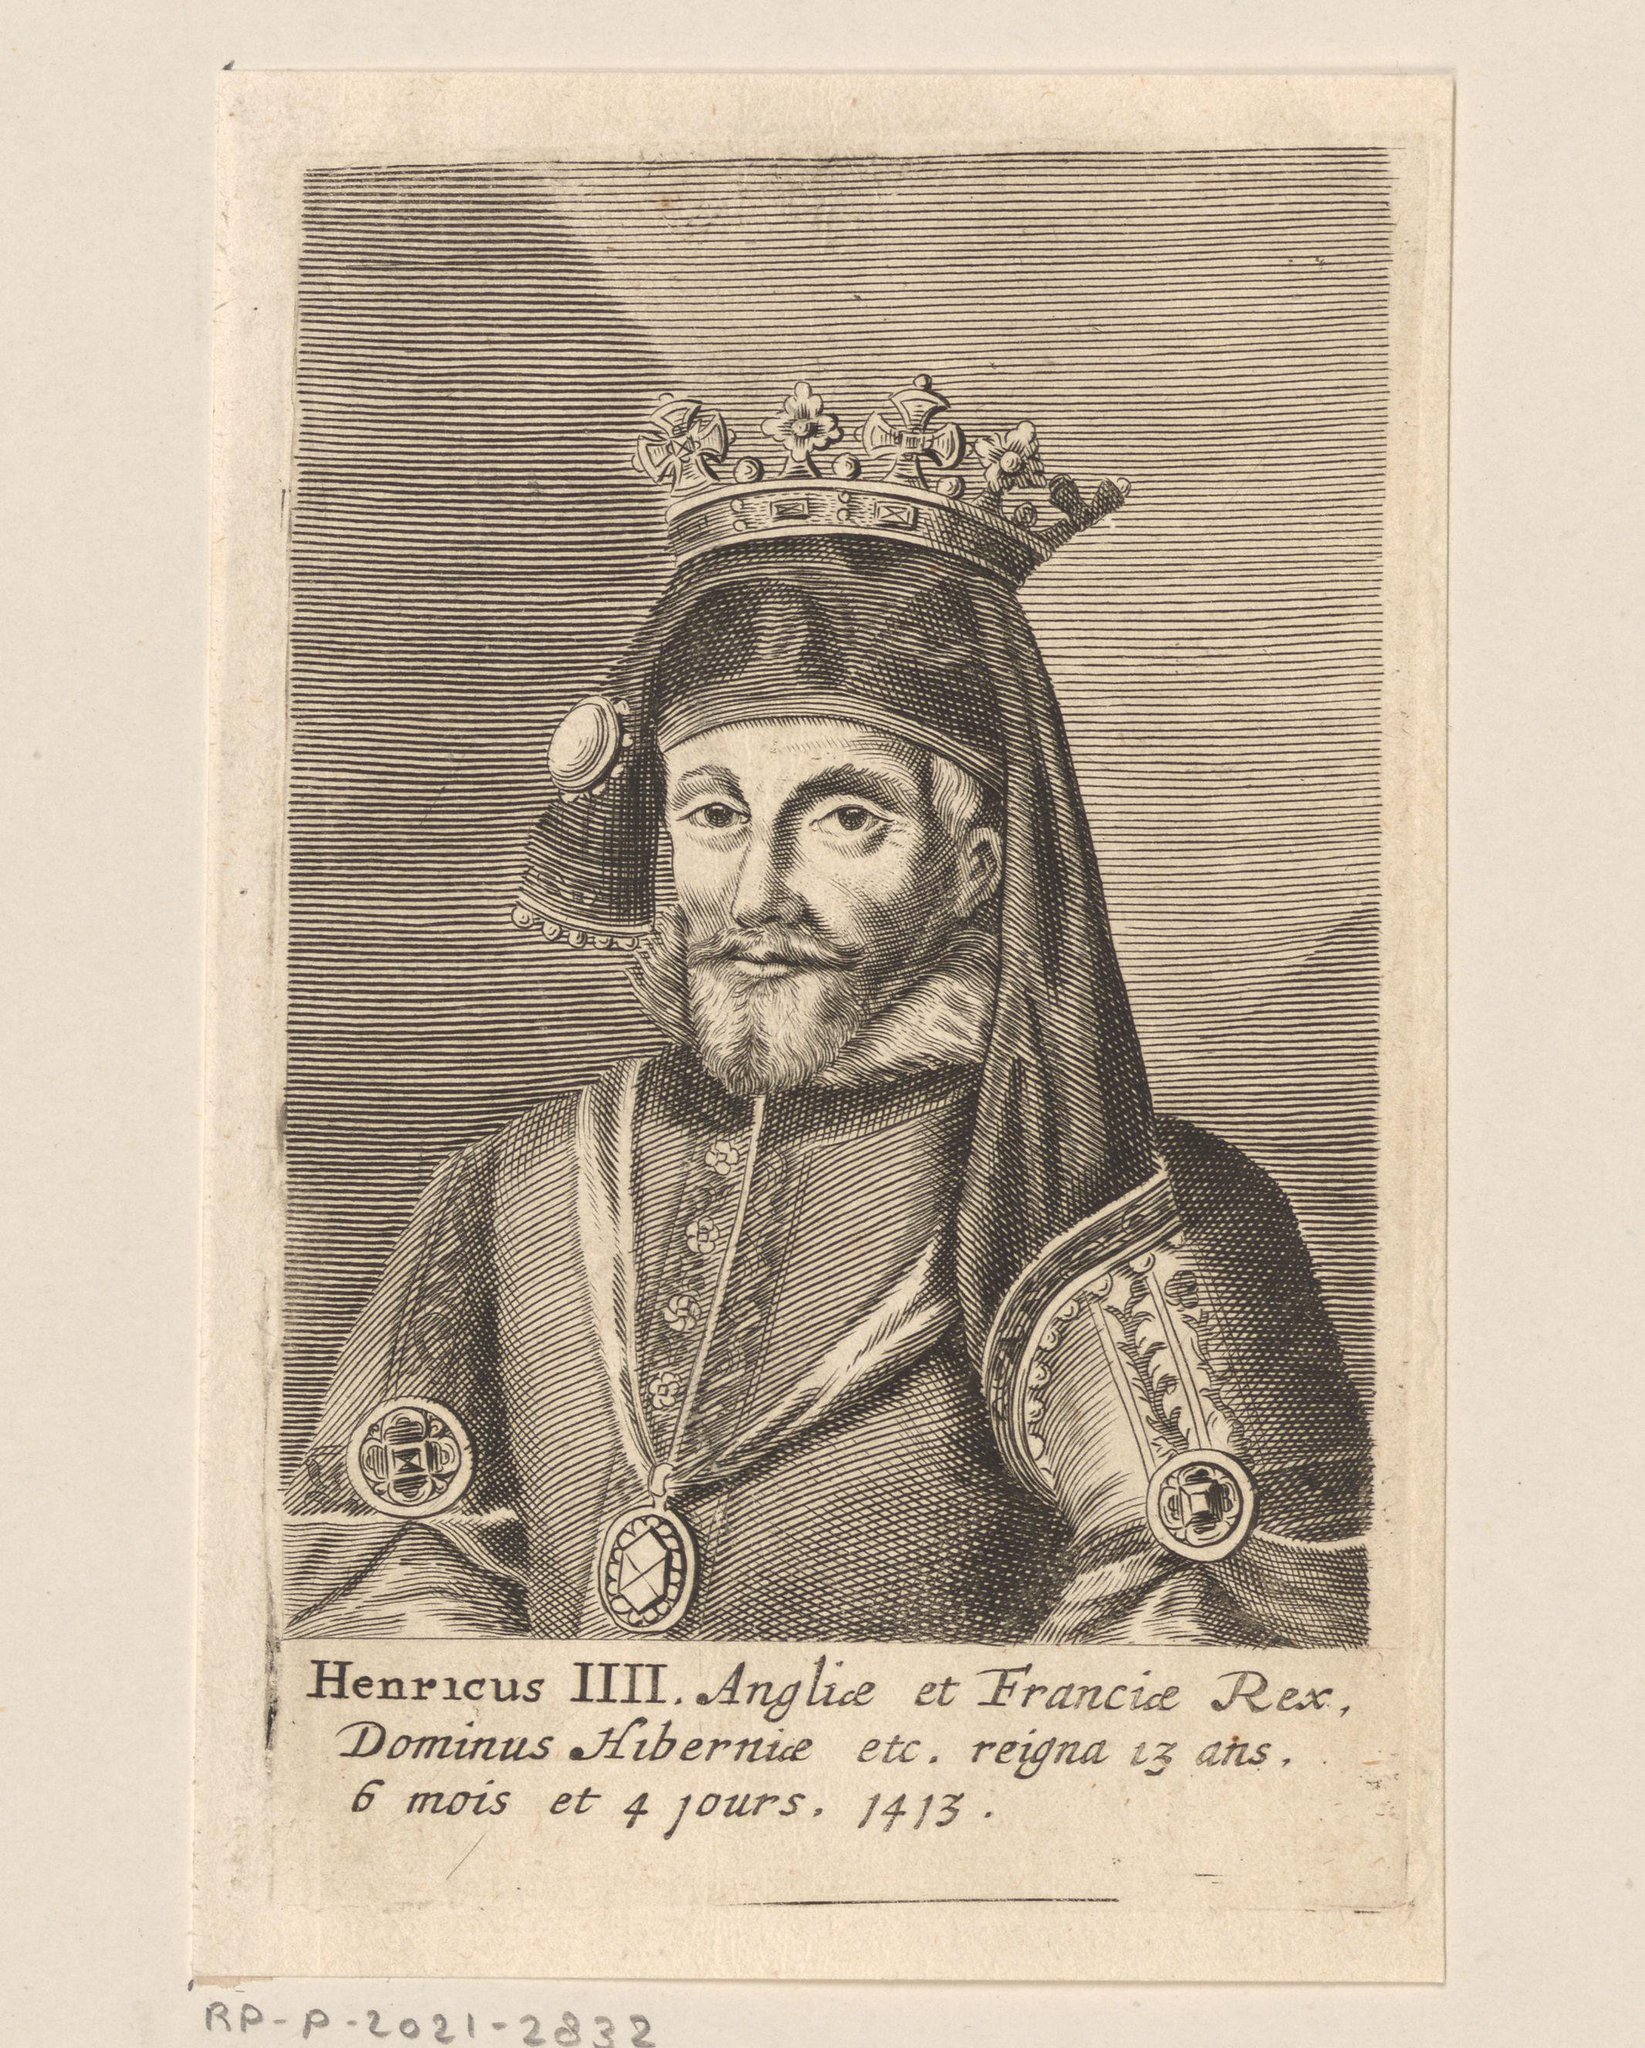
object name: book illustration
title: Portret van Hendrik IV, koning van Engeland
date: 1681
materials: paper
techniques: engraving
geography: amsterdam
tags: historical persons, king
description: Prent uit: Baker, Richard. Chronyck van het leven en bedrijf van al de koningen van Engelandt. Amsterdam: weduwe Jan Jacobsz. Schipper, 1681. Prent eerder gebruikt, met tekst op verso, in de eerste editie uitgegeven door Cornelis Dankertsz. in 1649.